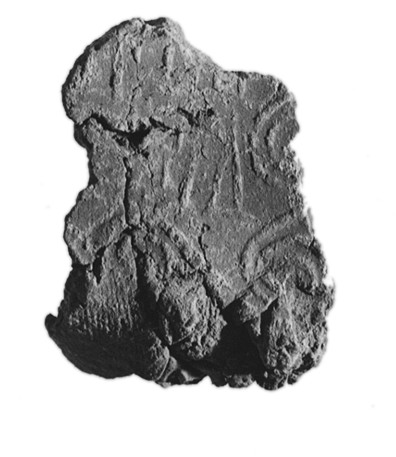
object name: sealing fragment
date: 2030-1640 BCE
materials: clay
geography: egypt